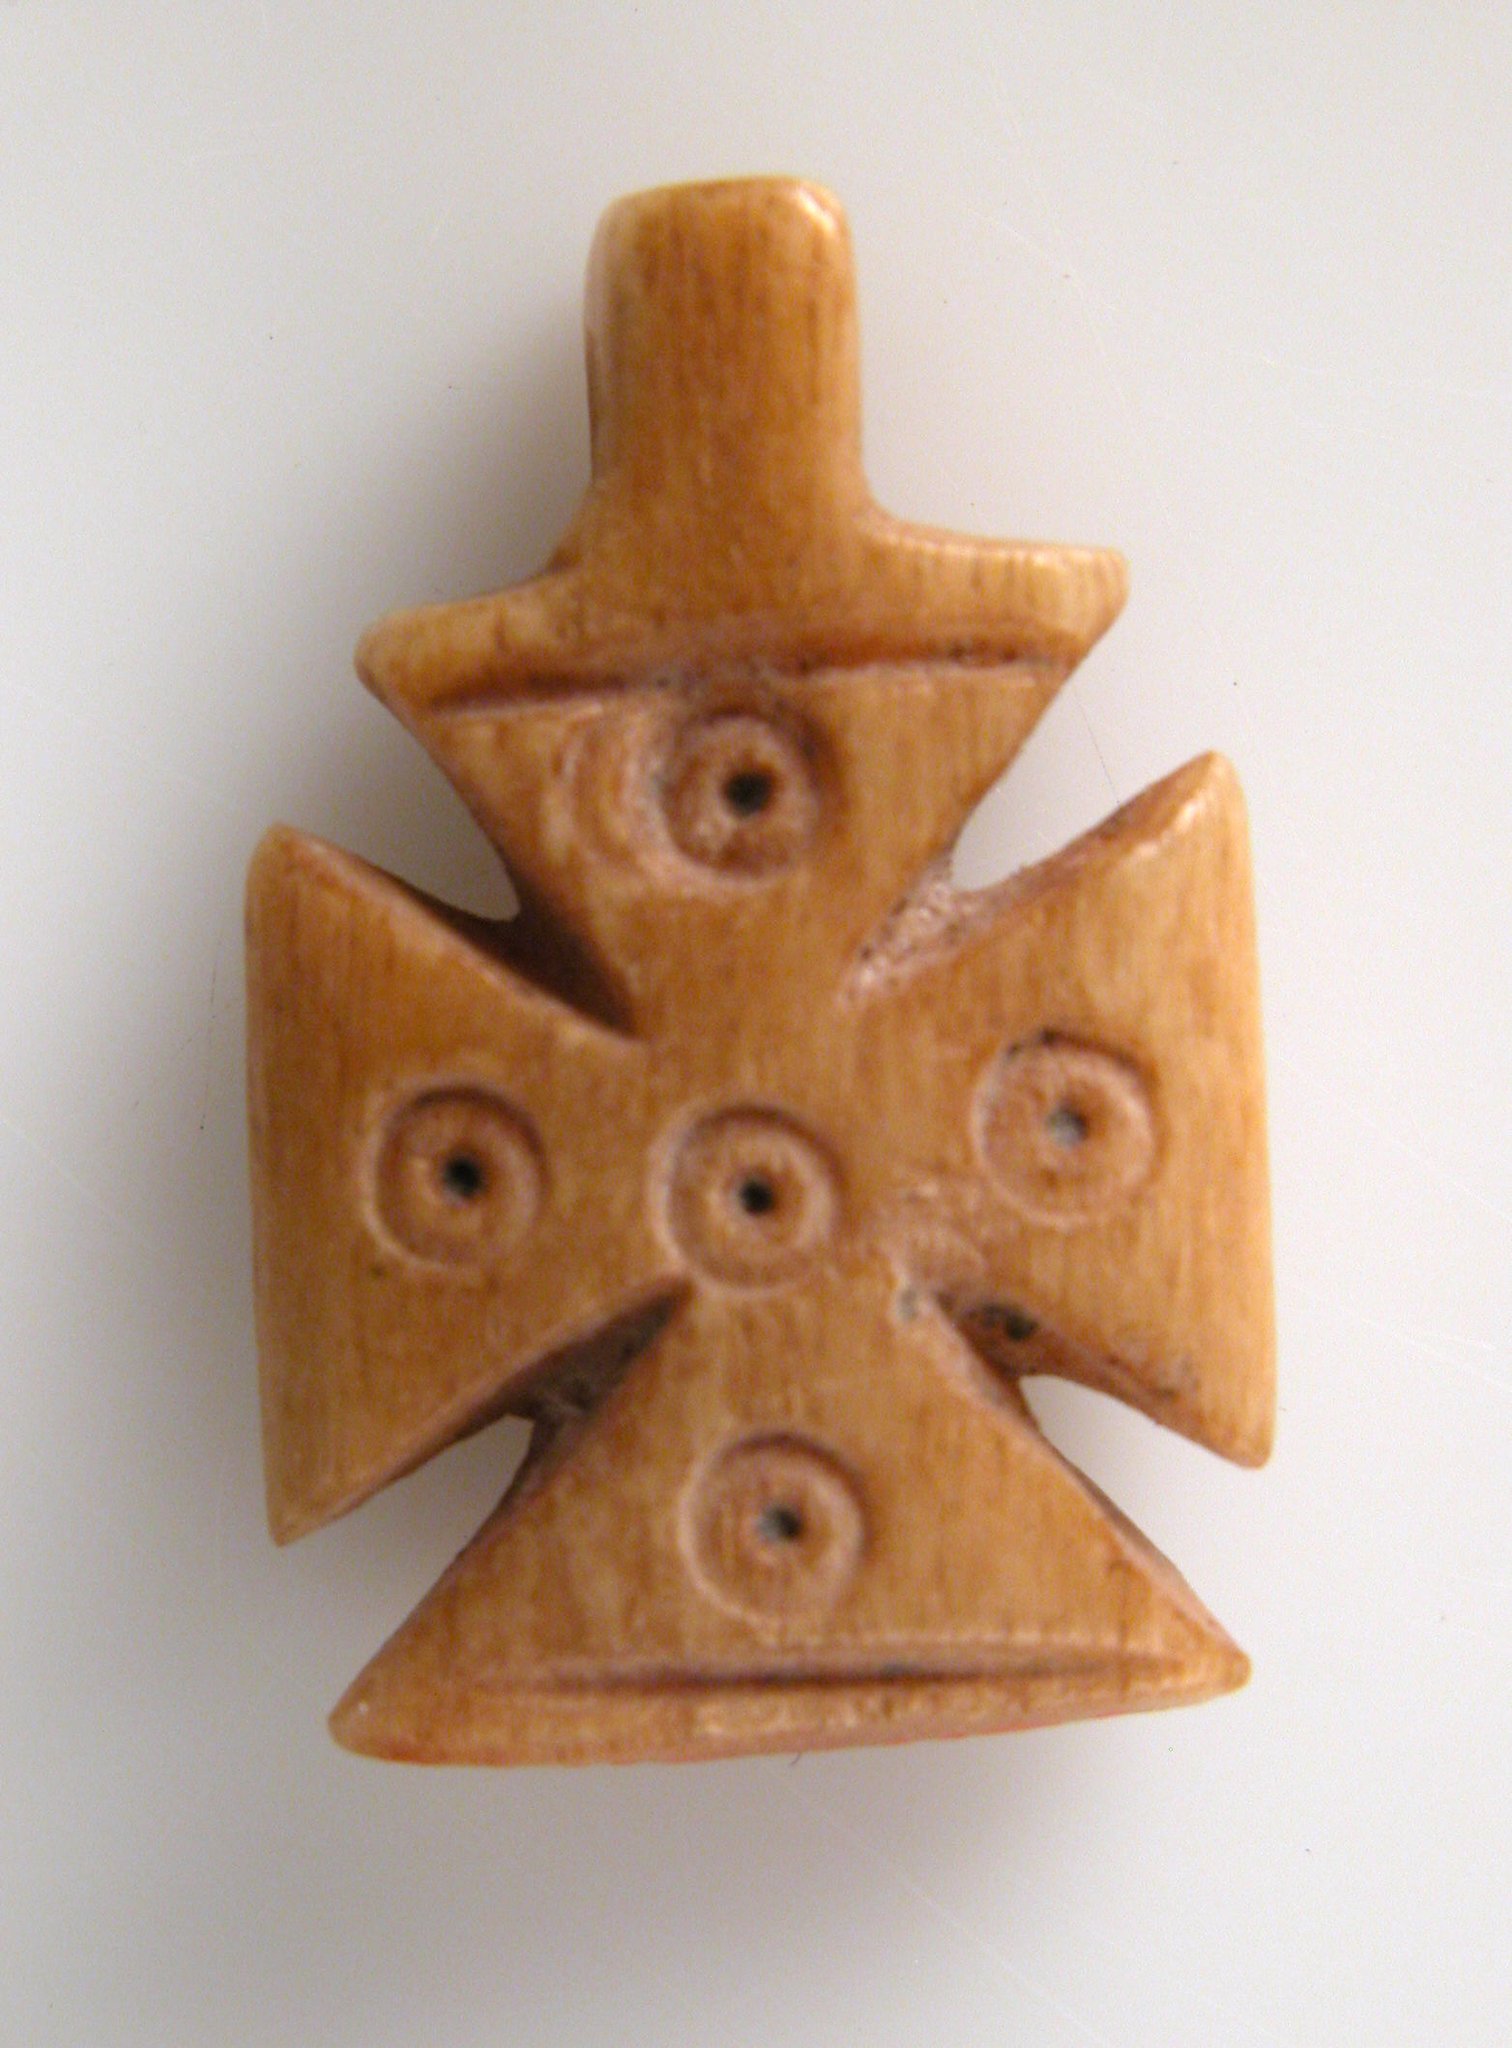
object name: pendant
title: Pendant Cross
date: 401-700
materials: bone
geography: egypt